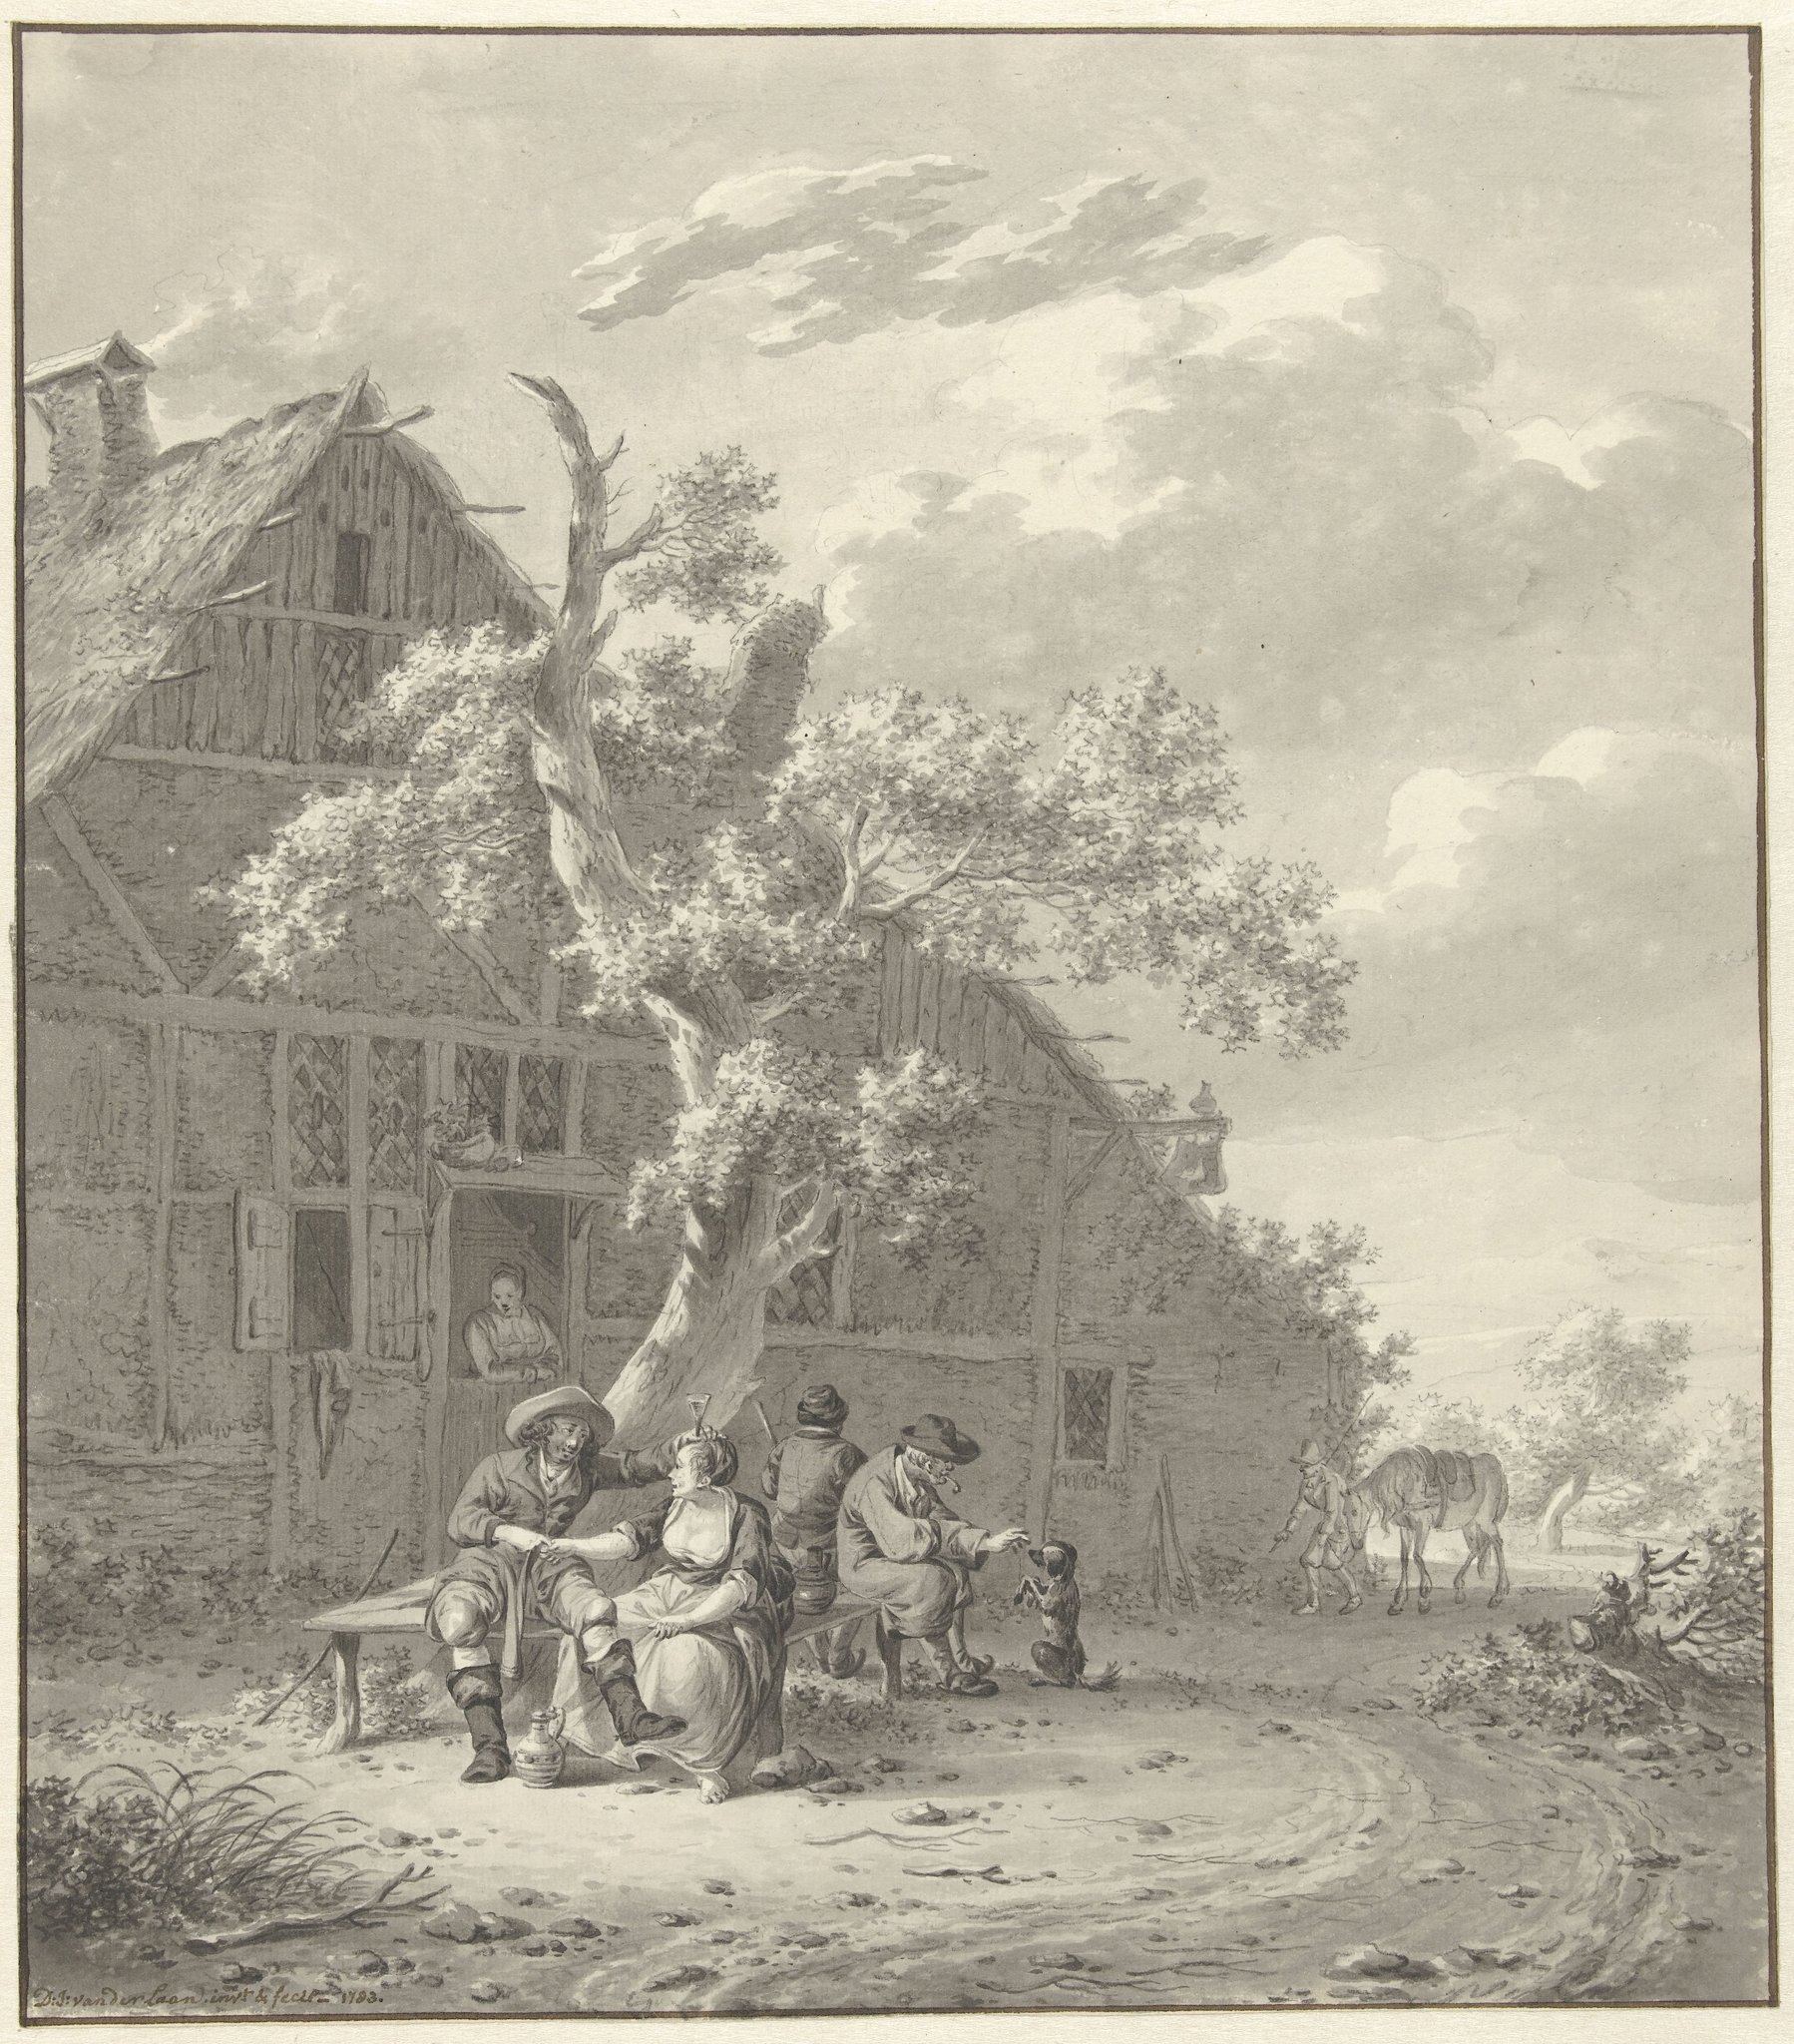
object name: drawing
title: Rustende wandelaars bij herberg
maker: dirk jan van der laan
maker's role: draughtsman, painter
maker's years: 1759-1829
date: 1783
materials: chalk, paper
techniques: brush